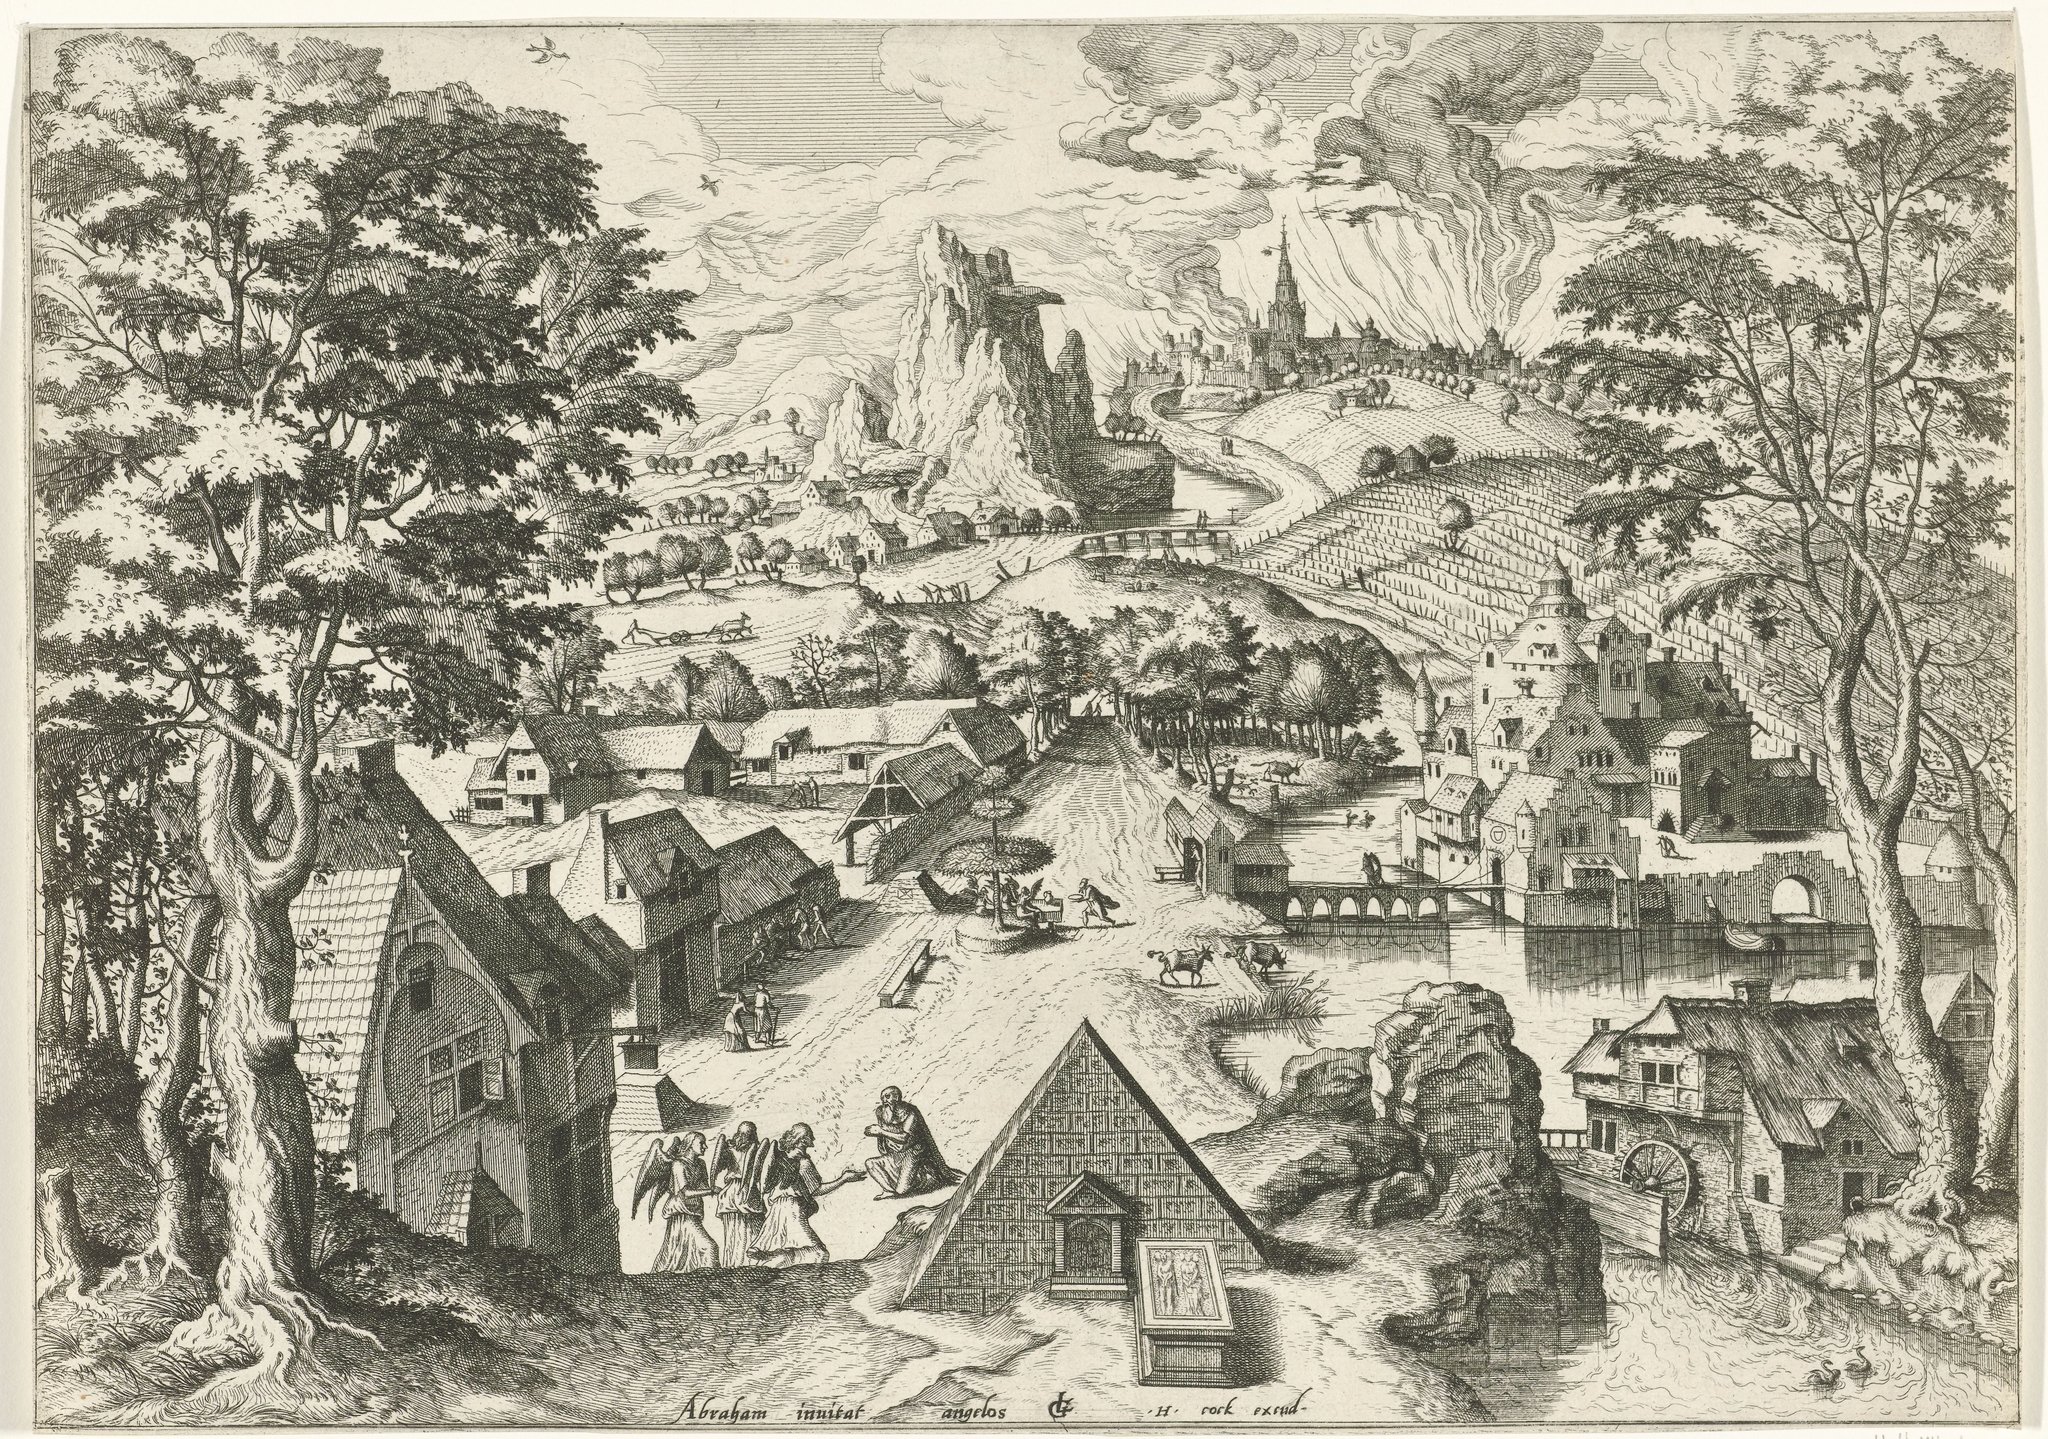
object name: print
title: Abraham met de engelen in een landschap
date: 1560-1564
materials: paper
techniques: engraving, etching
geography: deventer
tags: abraham kneels before the angels, pyramid (marking grave), abraham entertaining the three angels, sodom and gomorrah burning, dale, valley (+ landscape with figures, staffage)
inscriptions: collector's mark: Lugt 2166, collector's mark: Lugt 845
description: Landschap met centraal op de voorgrond Abraham die de drie engelen begroet (Gen. 18:2). Naast hem een piramide en een graftombe. Op de achtergrond geeft Abraham de engelen te eten. In de verte staat de stad Sodom in brand. De prent is deel van een serie van landschappen met christelijke verhalen als thema.